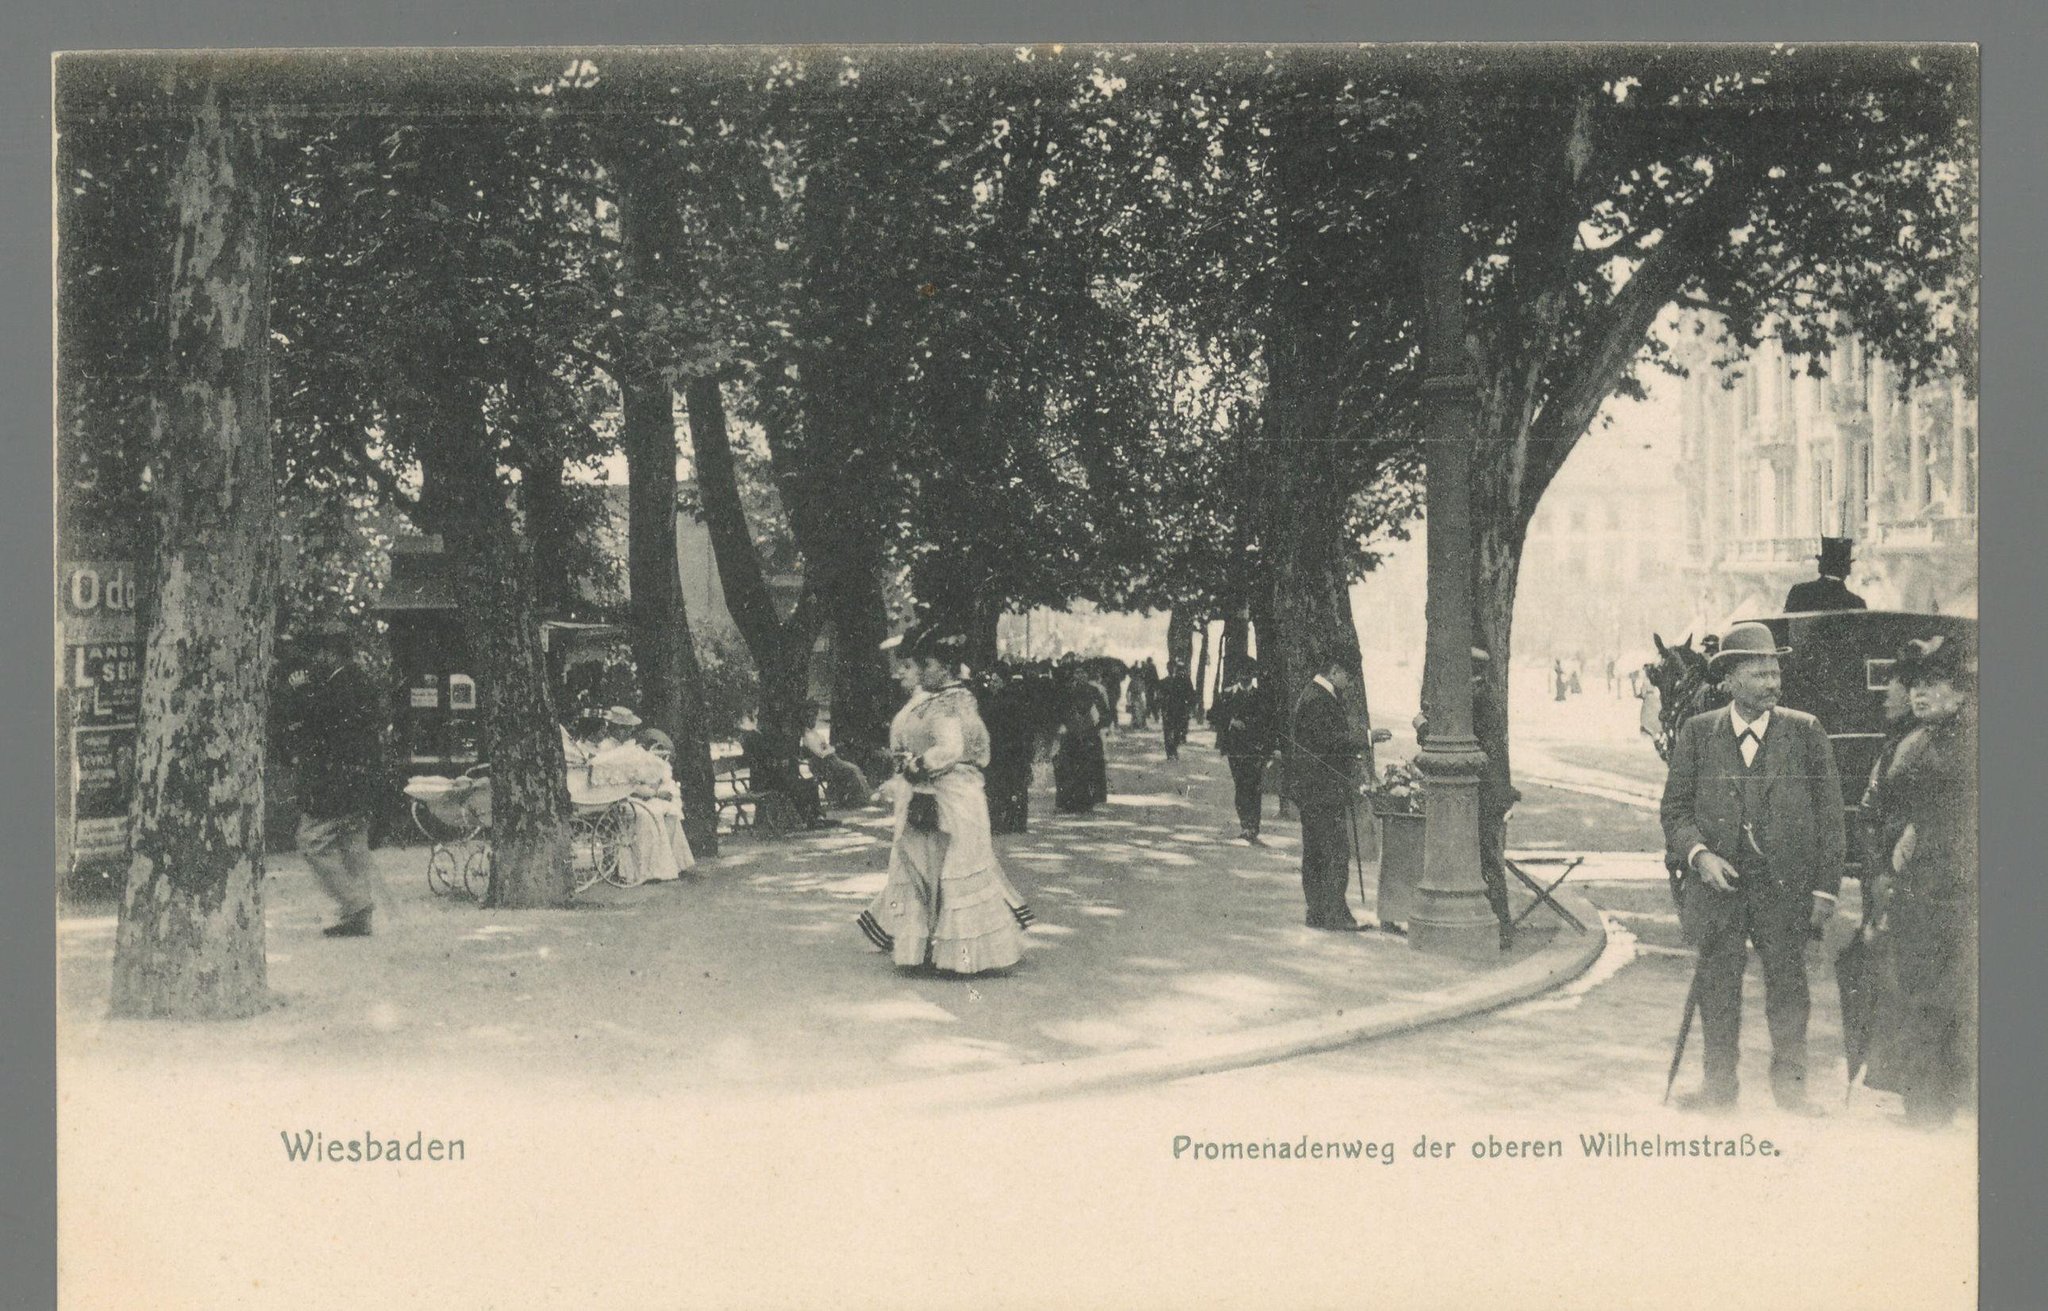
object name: ansichtkaart, prentbriefkaart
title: Wiesbaden. Promenadenweg der oberen Wilhelmstraβe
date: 1905-1930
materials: cardboard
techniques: photograph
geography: wiesbaden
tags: avenue, boulevard, promenade, esplanade